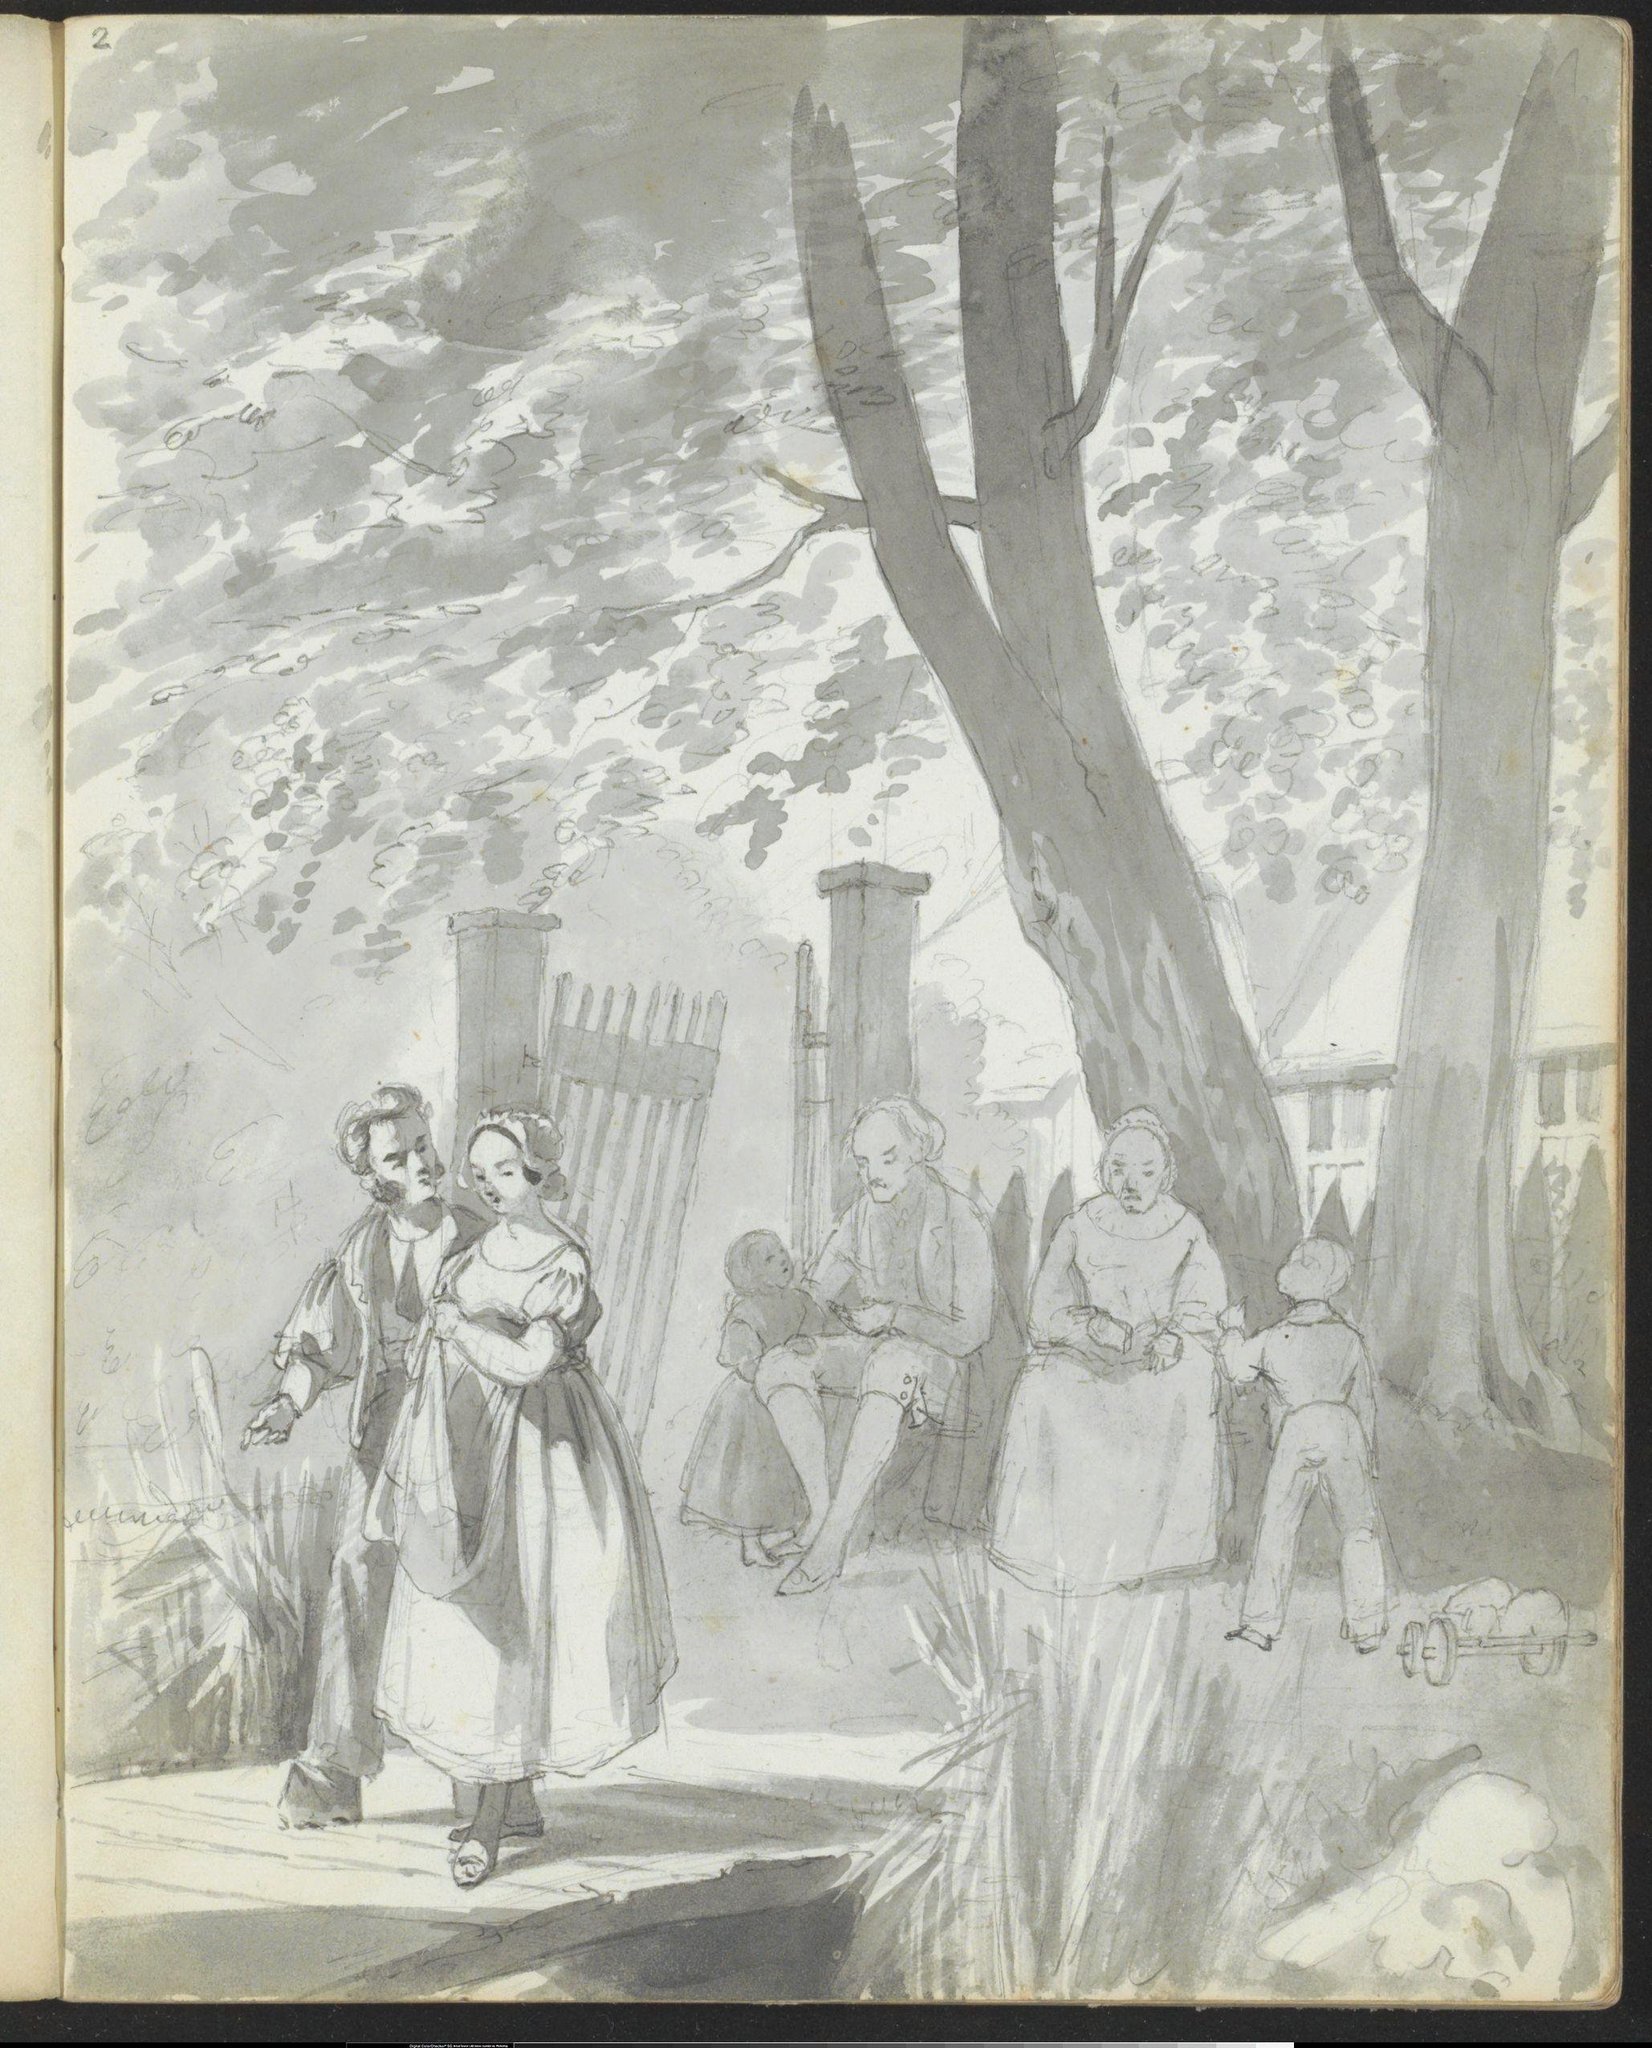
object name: sketchbook leaf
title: Paar op een brug voor een huis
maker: hendrik abraham klinkhamer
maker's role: draughtsman, painter, print maker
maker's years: 1810-1872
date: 1820-1872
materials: paper, pencil, watercolor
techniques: brush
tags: parents with their children, rural housing, e.g. country-house, villa, cottage, bridge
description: Achter de man en vrouw, bij de hek voor het huis, zit een ouder paar met twee kinderen. Blad 2 recto uit een schetsboek met 21 bladen.